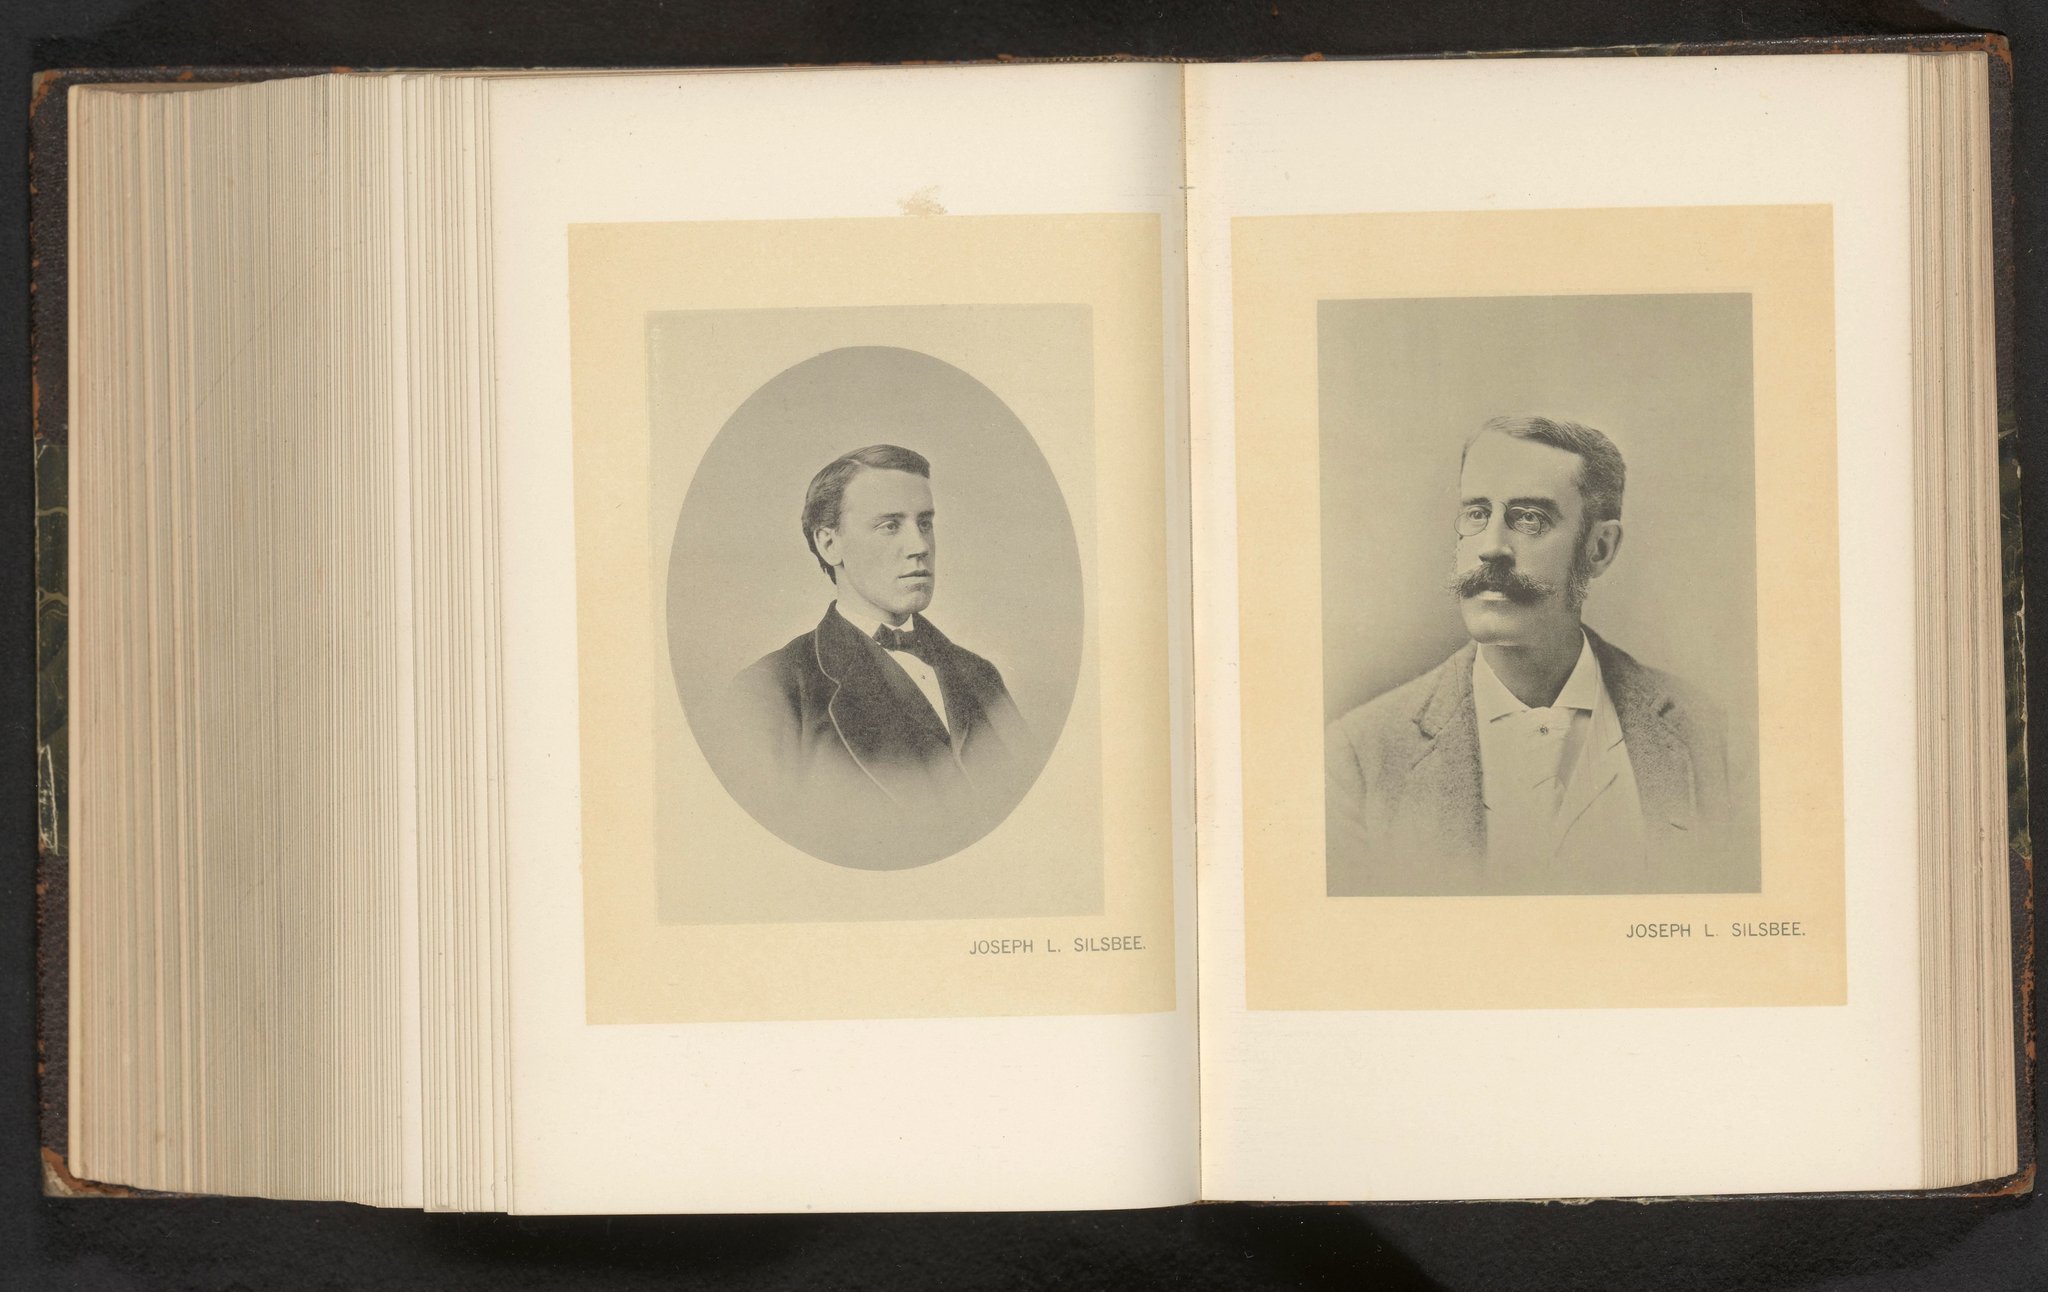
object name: photomechanical print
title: Joseph L. Silsbee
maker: Anonymous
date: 1889-1894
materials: paper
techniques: photoaquatint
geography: boston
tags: portrait, self-portrait of architect